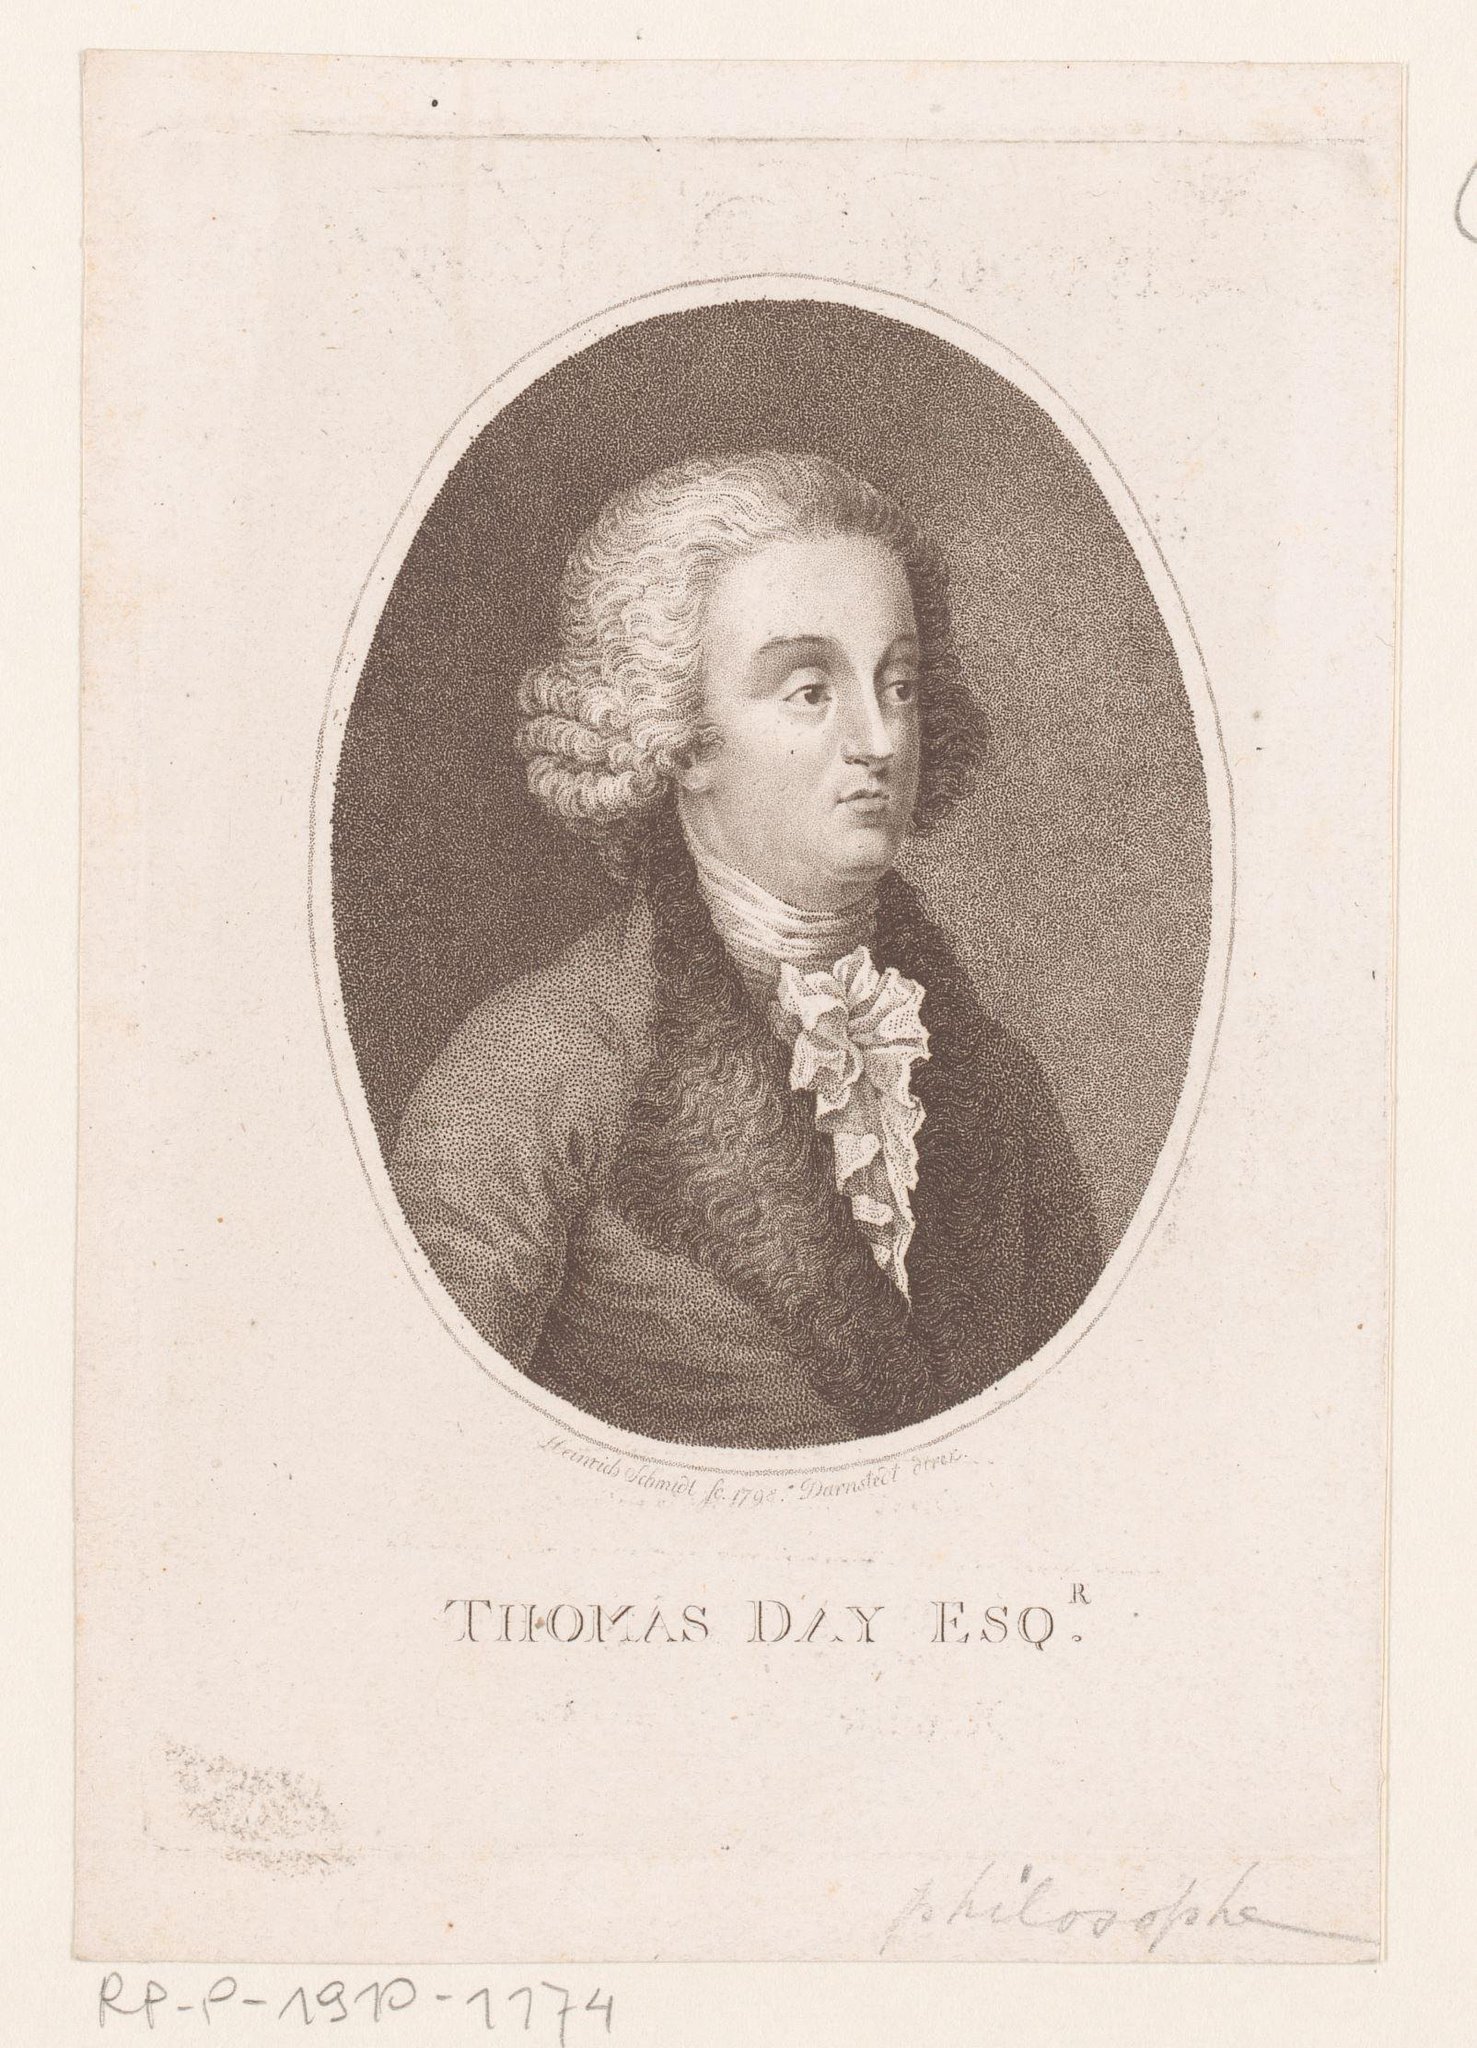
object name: print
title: Portret van Thomas Day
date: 1750-1821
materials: paper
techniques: engraving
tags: historical persons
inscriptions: collector's mark: Lugt 2228